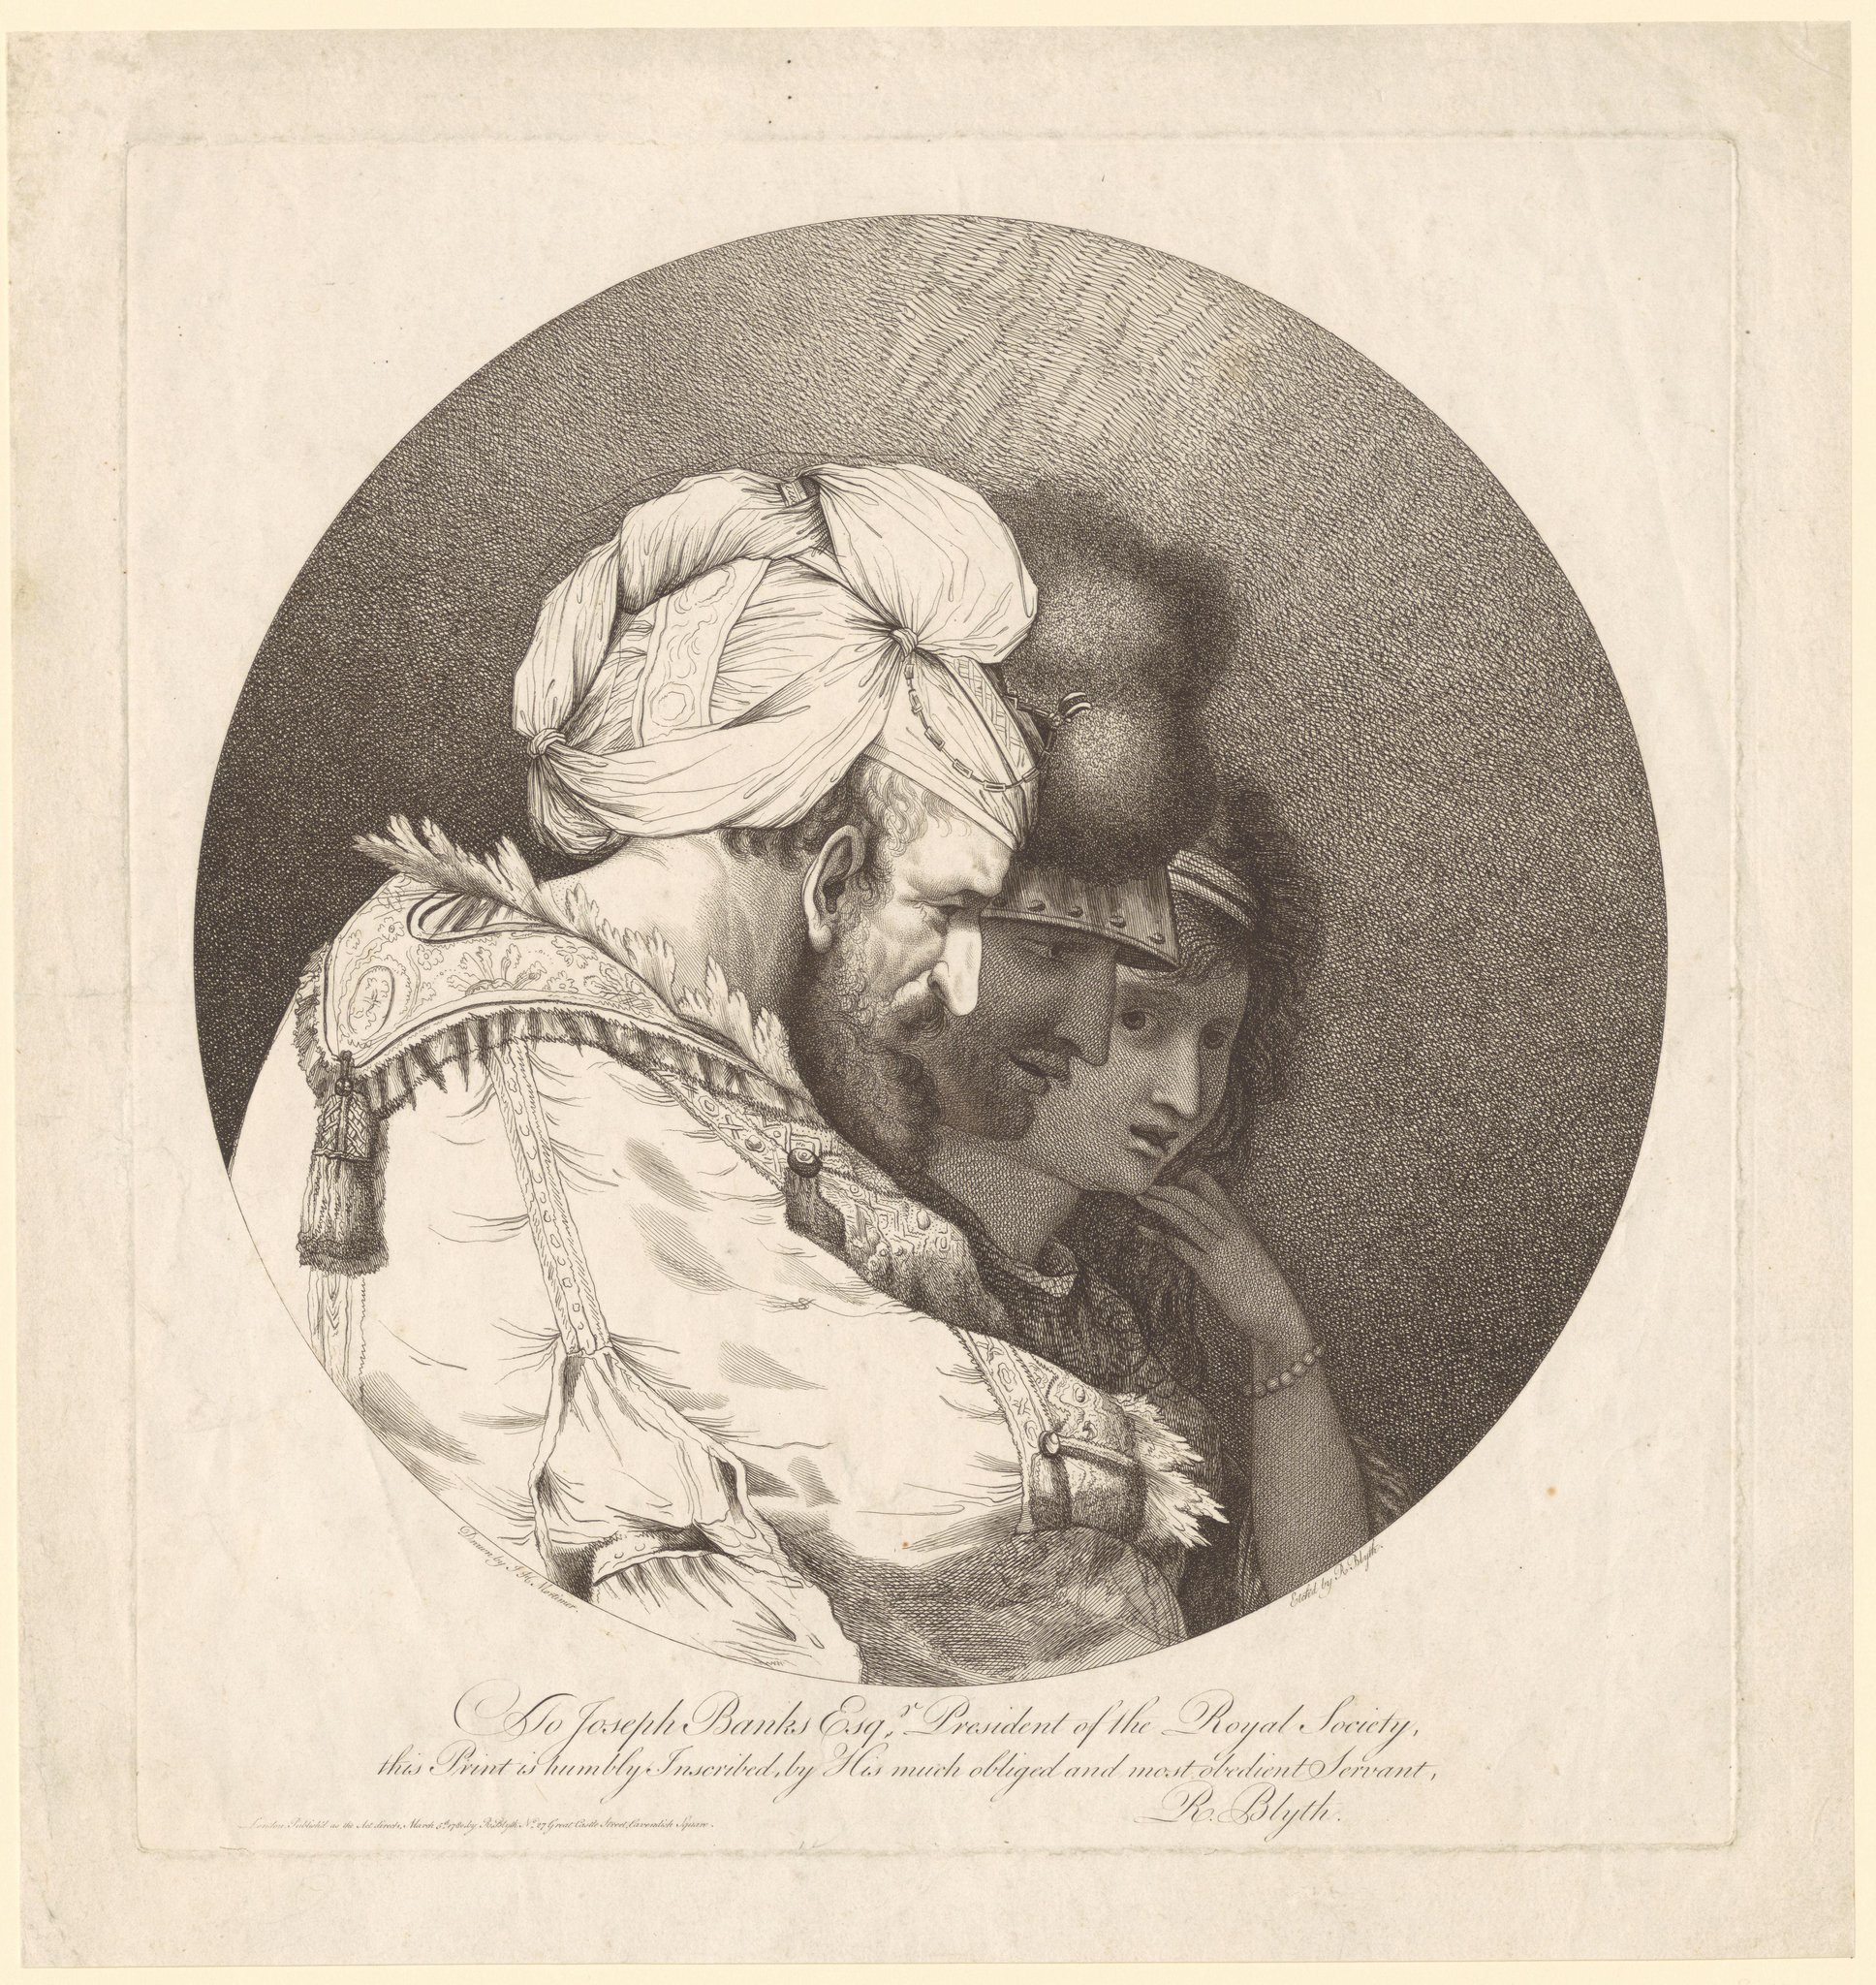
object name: print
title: Drie hoofden van een man met tulband, man met helm en een vrouw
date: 1703-1780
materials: paper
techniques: etching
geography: london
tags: helmet, head (human) (+ three-quarter view), head (human) (+ sideview, profile), head-gear: turban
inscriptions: collector's mark: Lugt 2760, collector's mark: Lugt 2228